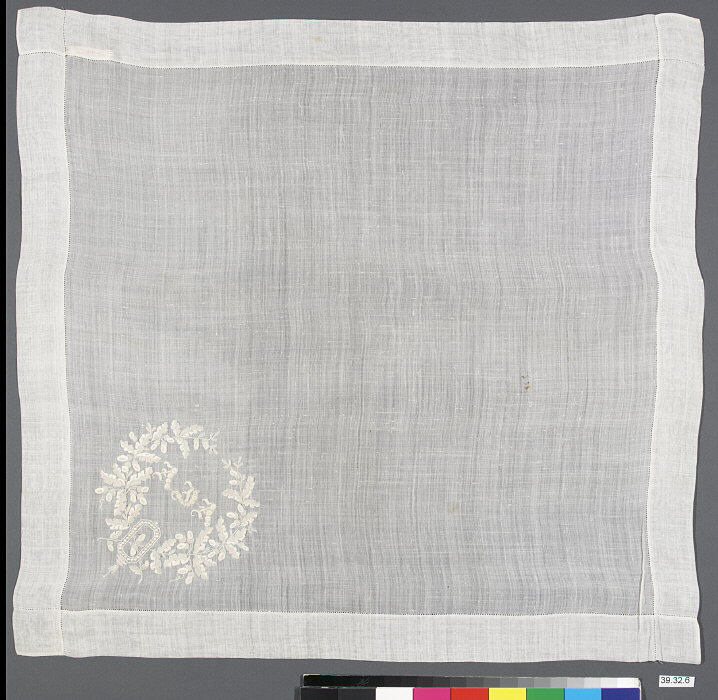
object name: handkerchief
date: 1801-1900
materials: cotton